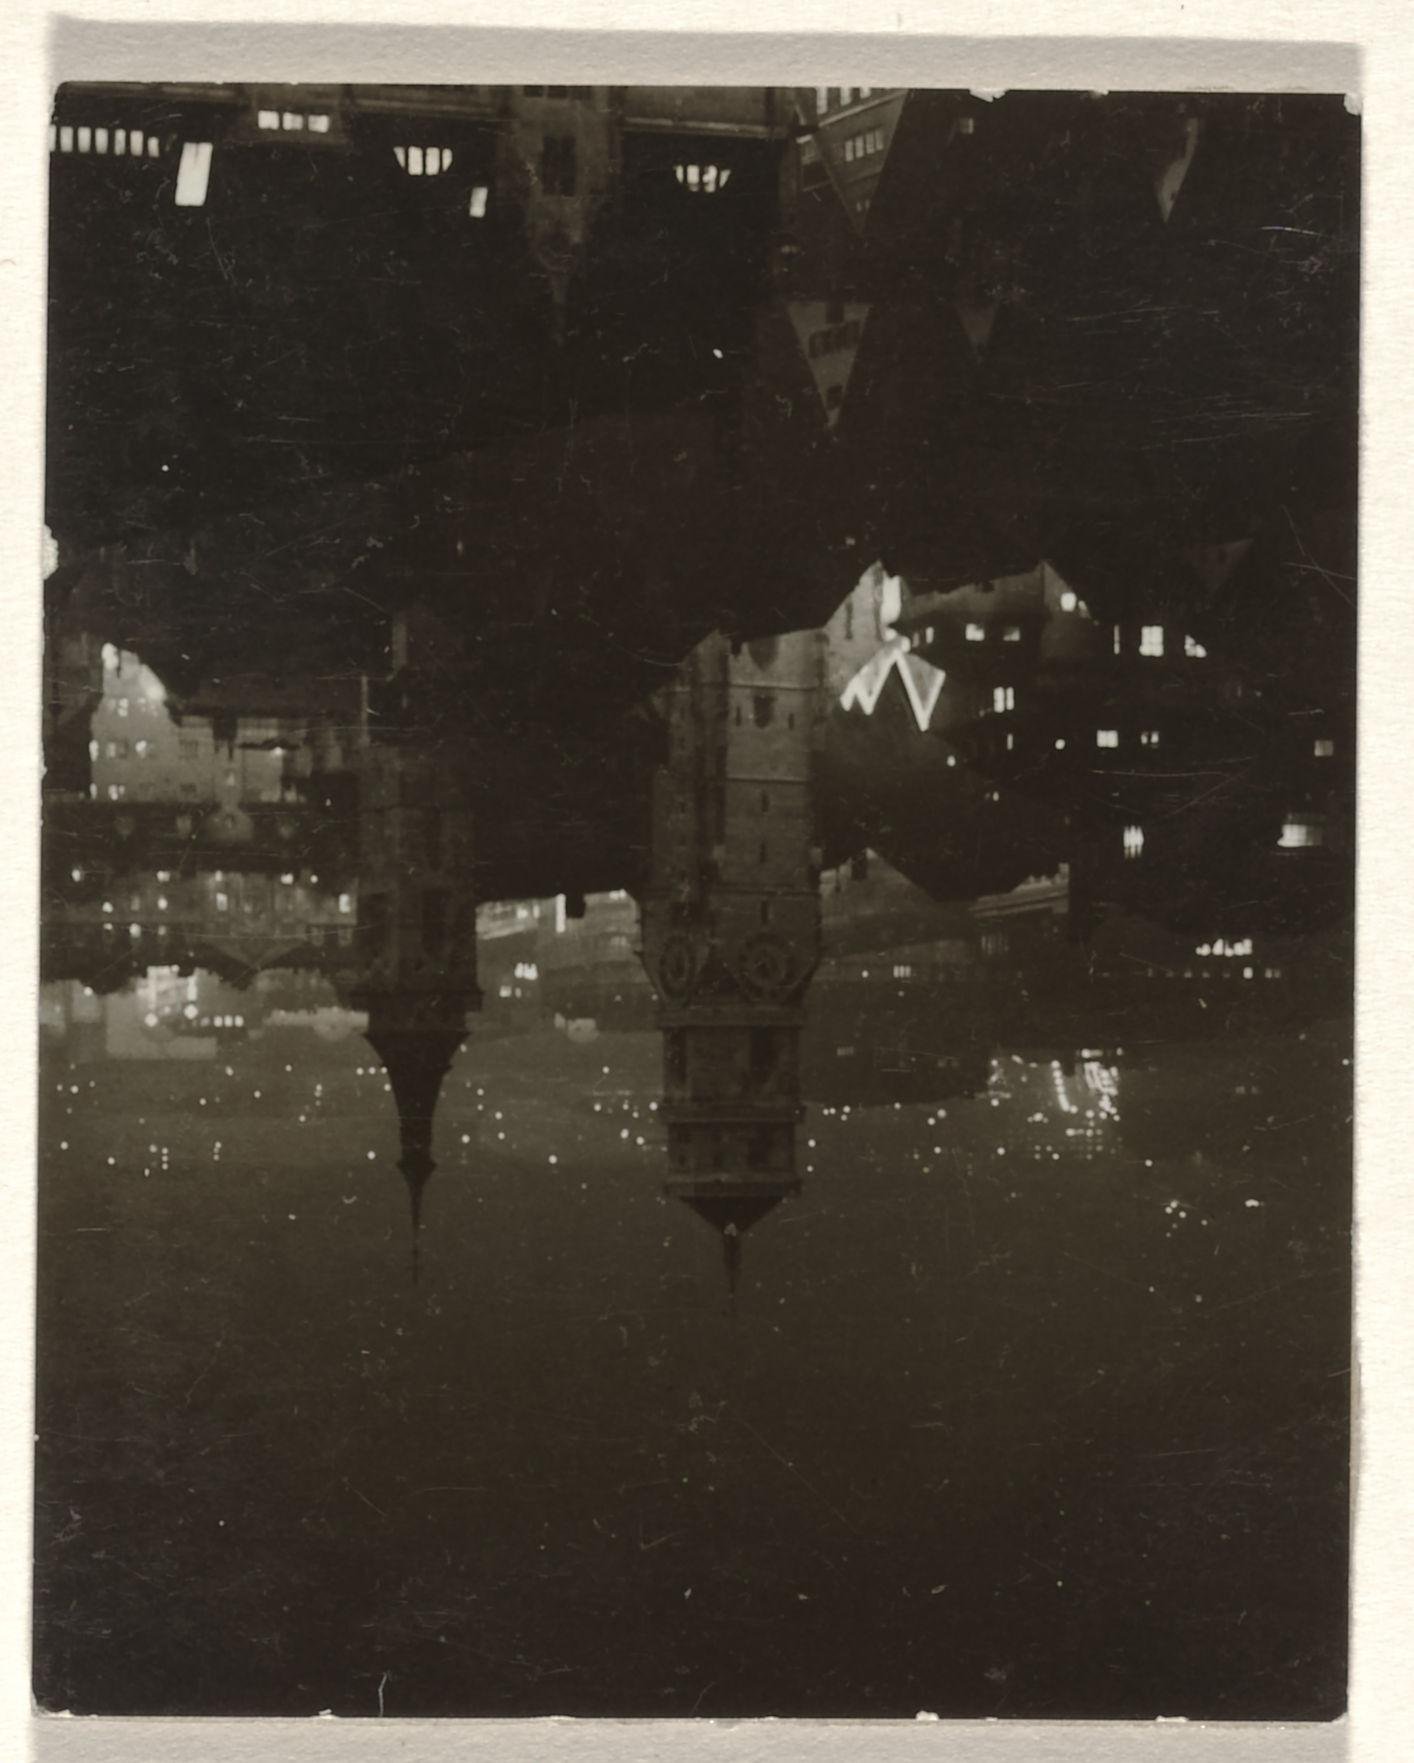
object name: photograph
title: Donkere luchtfoto van een stad met een kerktoren in het midden, genomen bij nacht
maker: Anonymous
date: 1930-1965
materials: photographic support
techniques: gelatin silver print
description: Donkere luchtfoto van een stad met een kerktoren in het midden, genomen bij nacht.